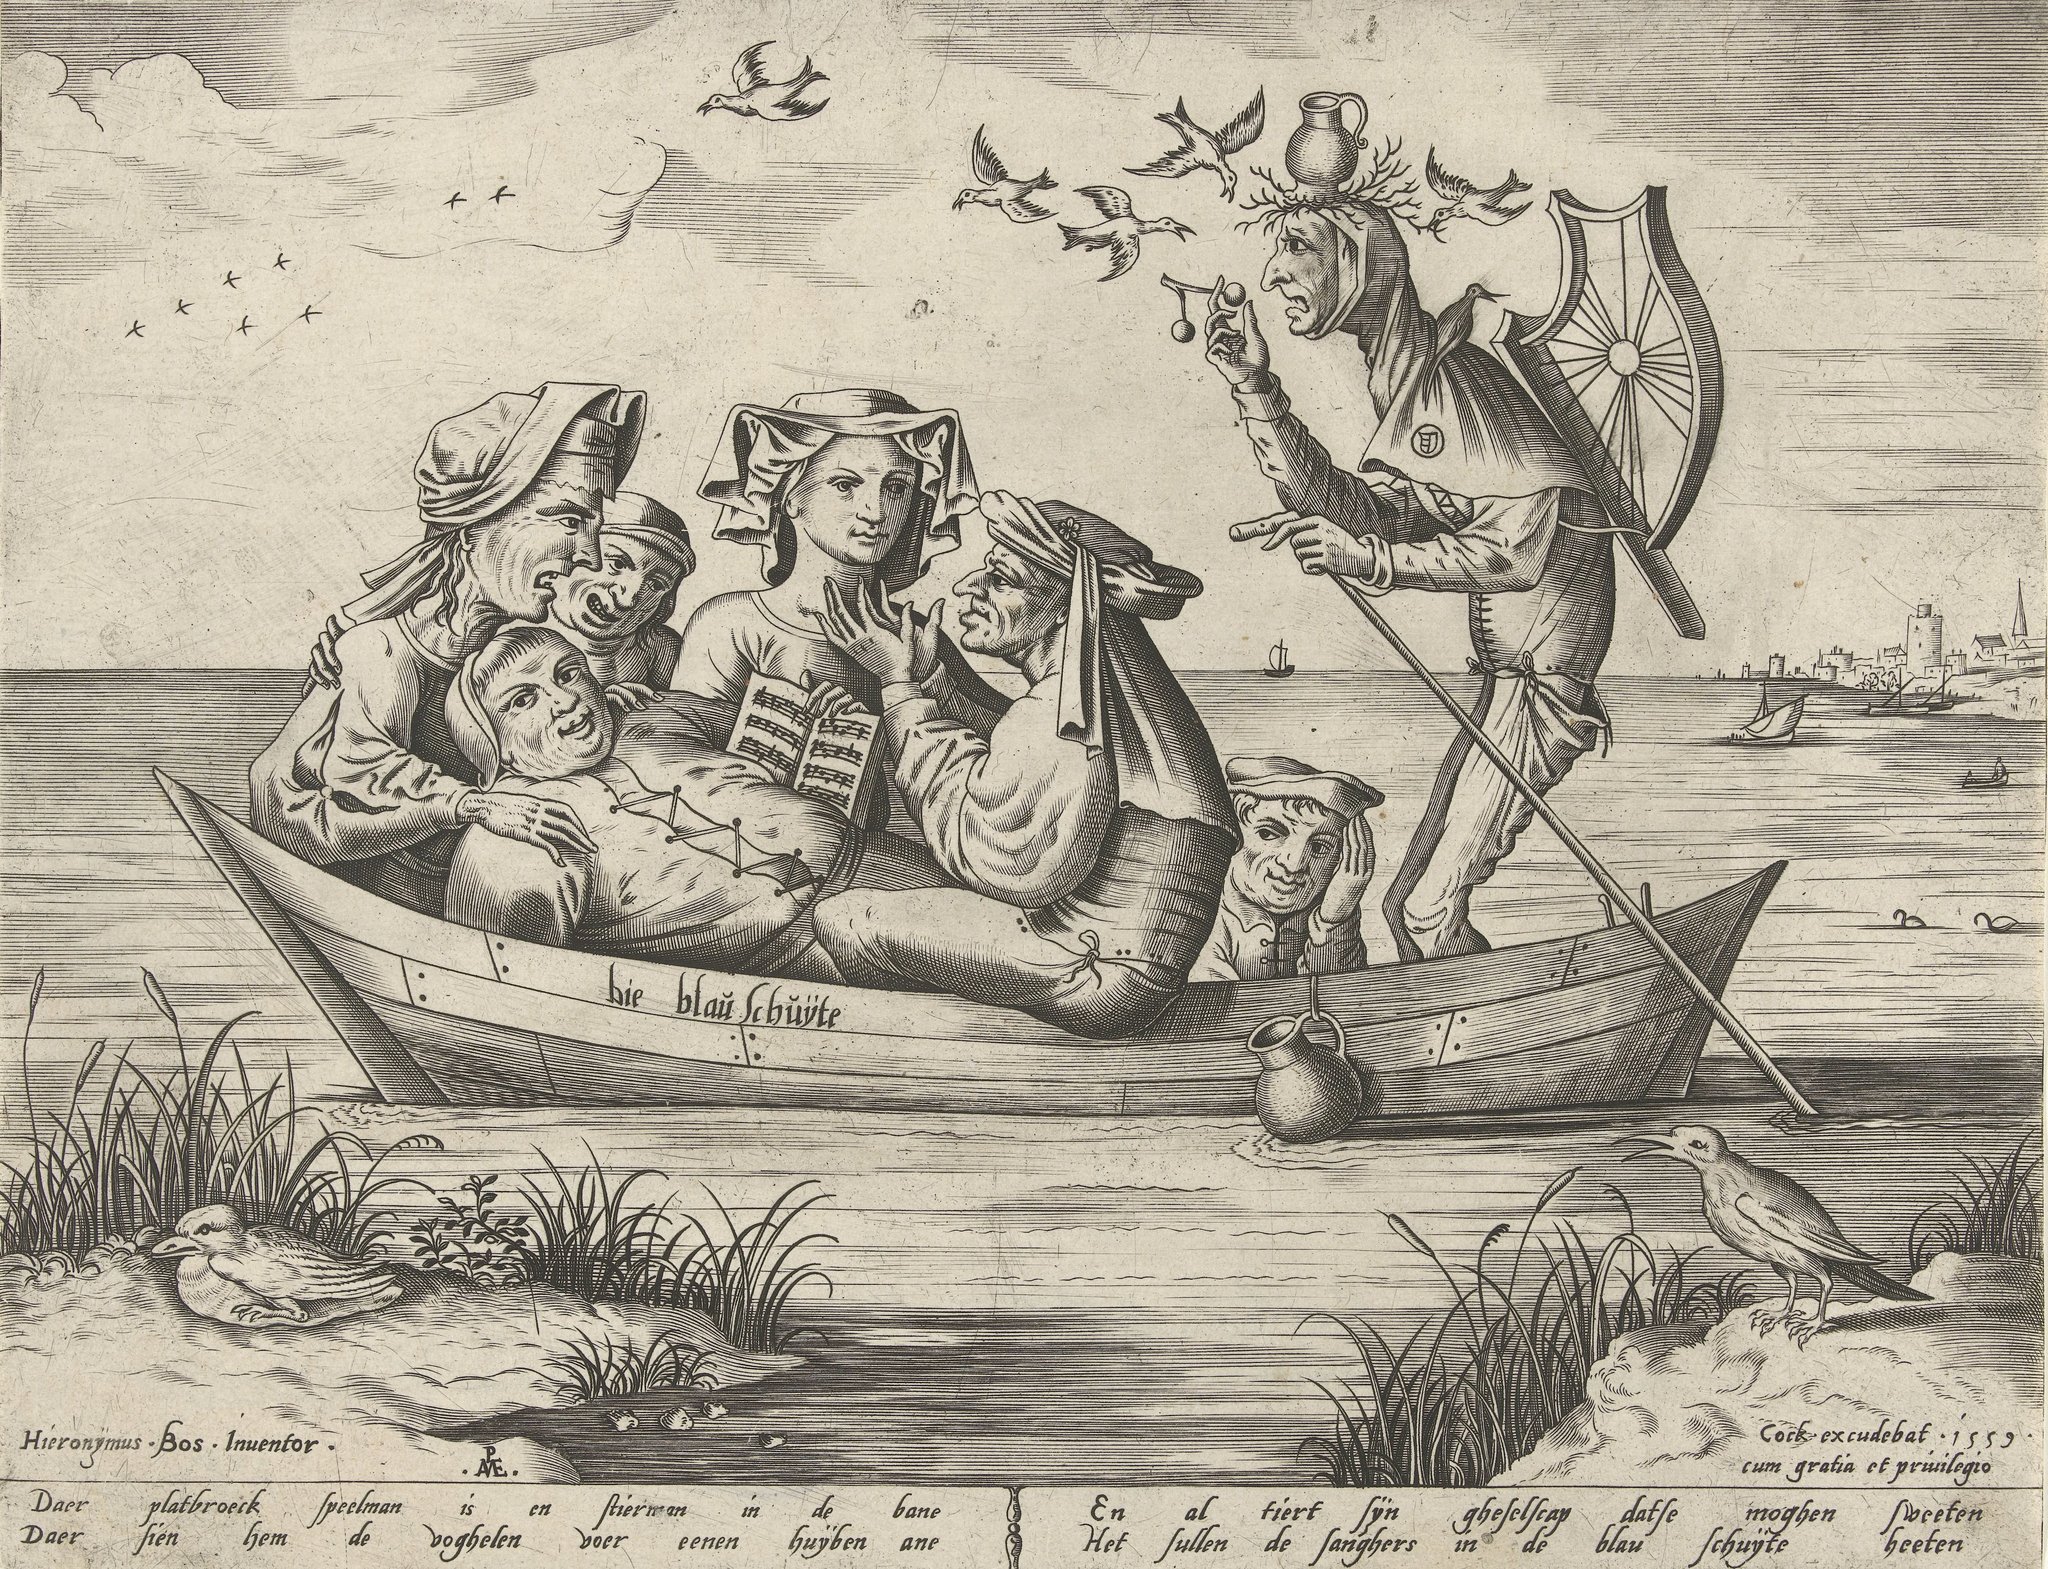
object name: print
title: Bie blau schuijte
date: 1559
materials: paper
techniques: engraving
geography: antwerp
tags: ship of fools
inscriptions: collector's mark: Lugt 2228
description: Het bootje met het opschrift ‘bie blau schuyte’ heeft een speelman als punterman met een snaarinstrument op zijn rug en een kan op het hoofd. In de boot bevinden zich nog zes figuren waaronder een liggende dikke man met een liedboek en twee vrouwen. Onder de voorstelling een vierregelig vers in het Nederlands in twee kolommen, verwijzend naar dranklust, losbandigheid en verdorvenheid.